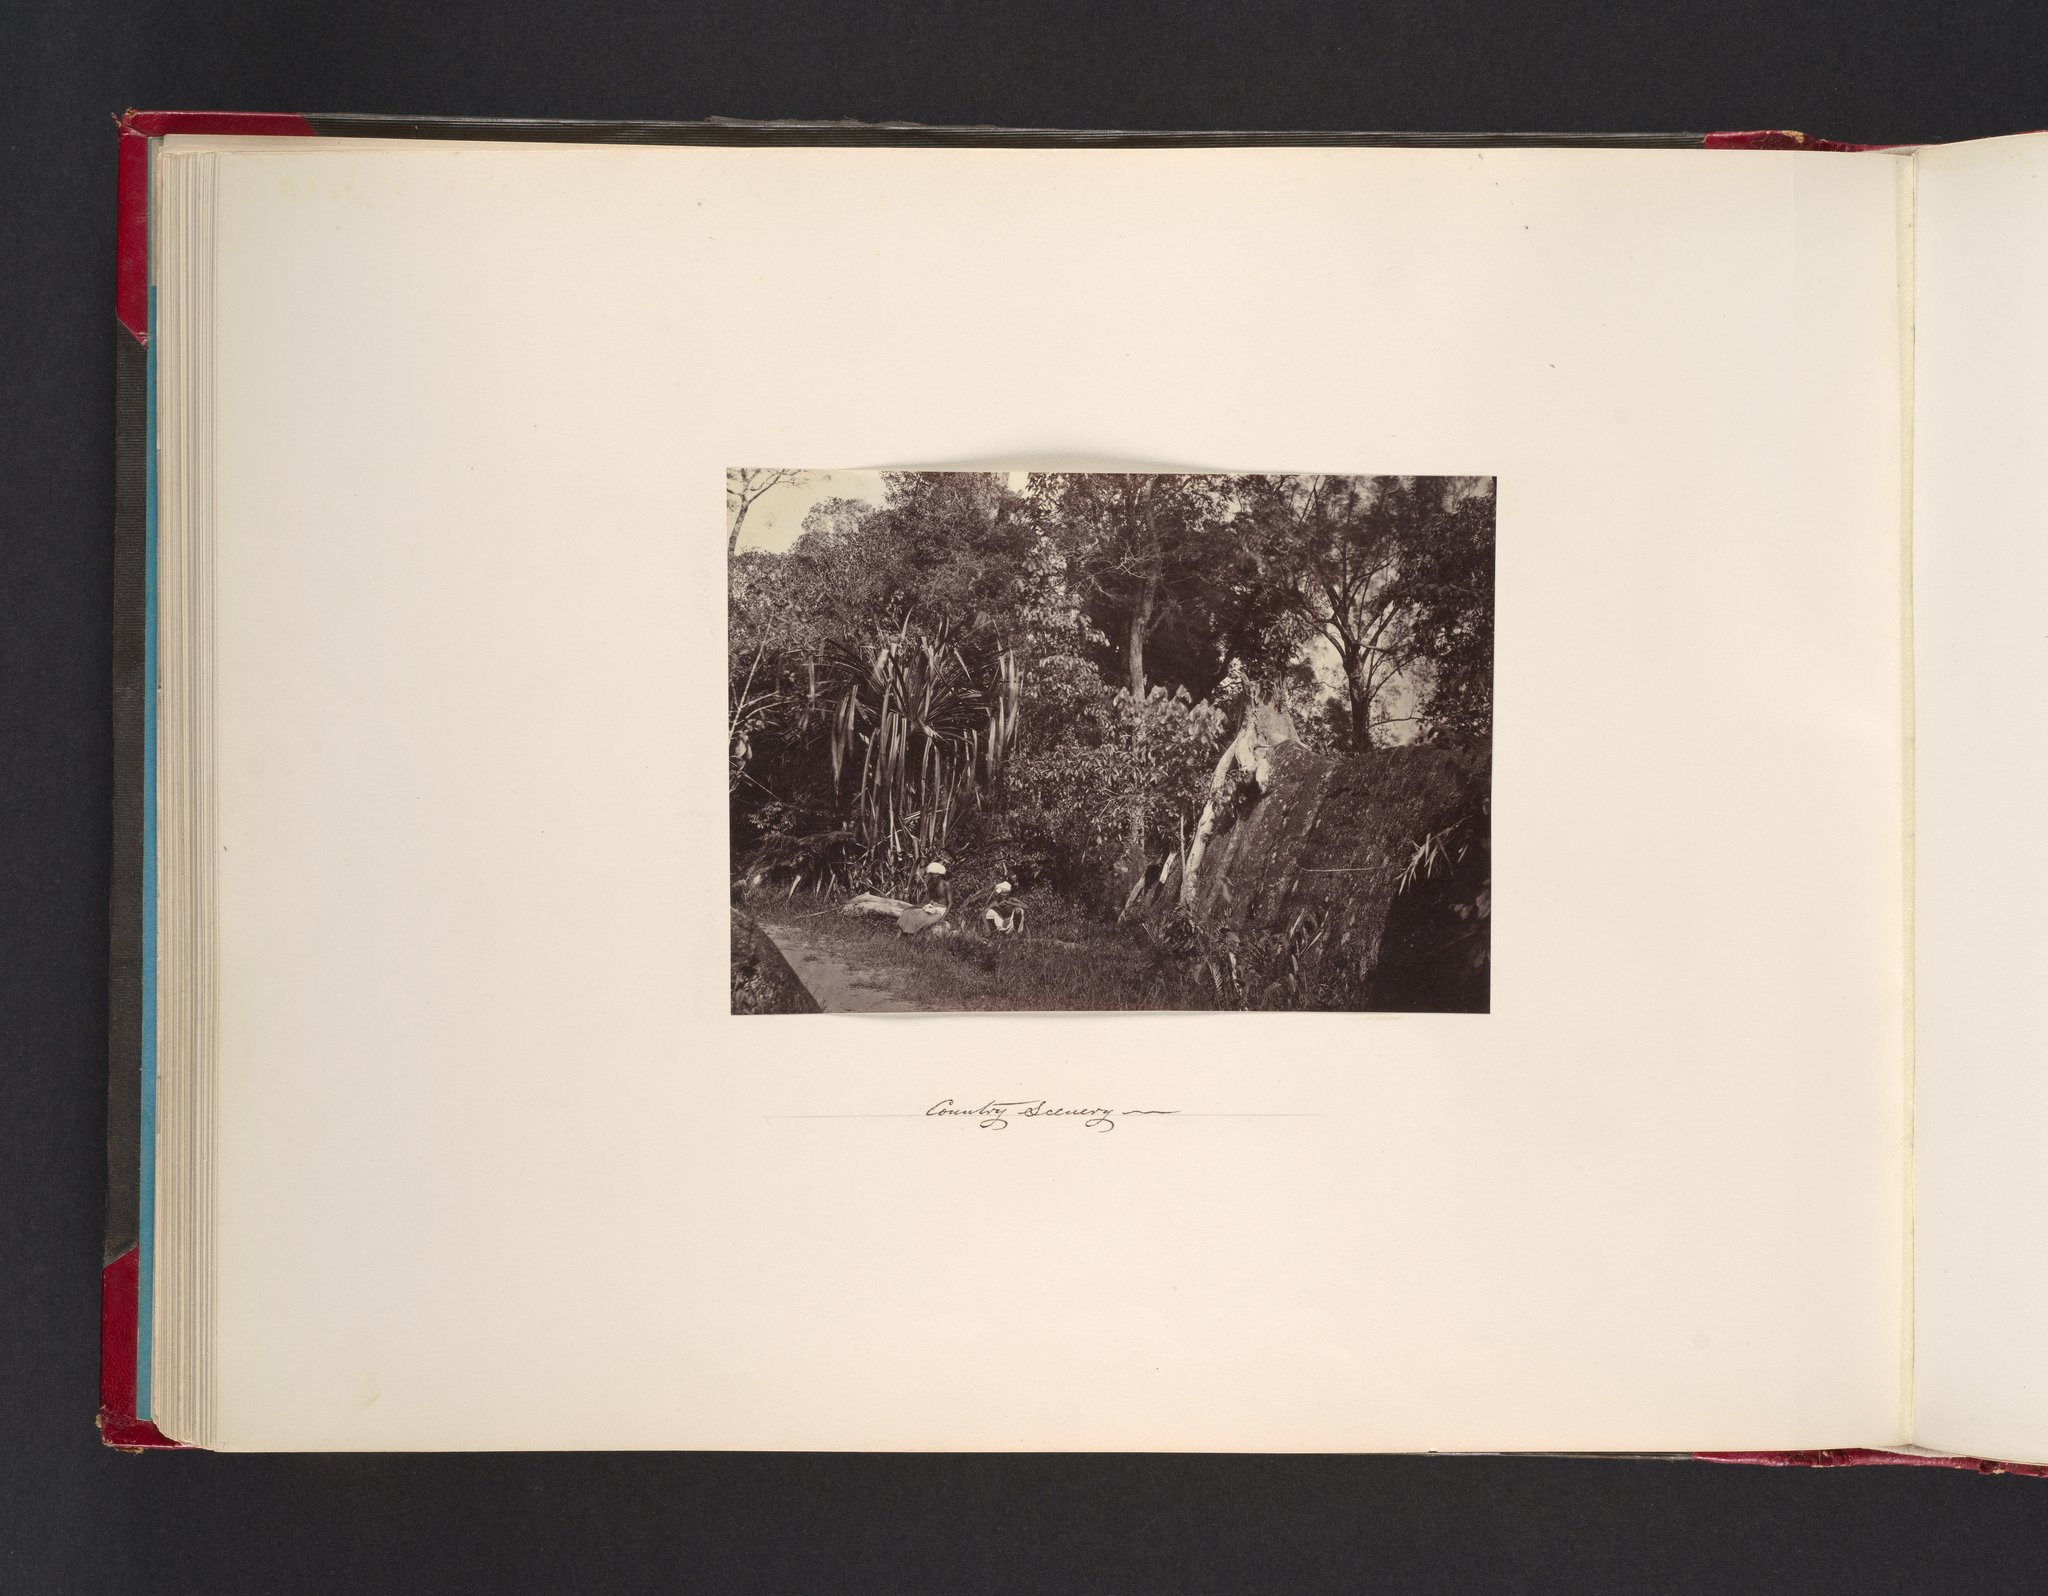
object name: photograph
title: Country Scenery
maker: john thomson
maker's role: artist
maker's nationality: british, scottish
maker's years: 1837-1921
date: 1865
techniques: albumen silver print, glass negative